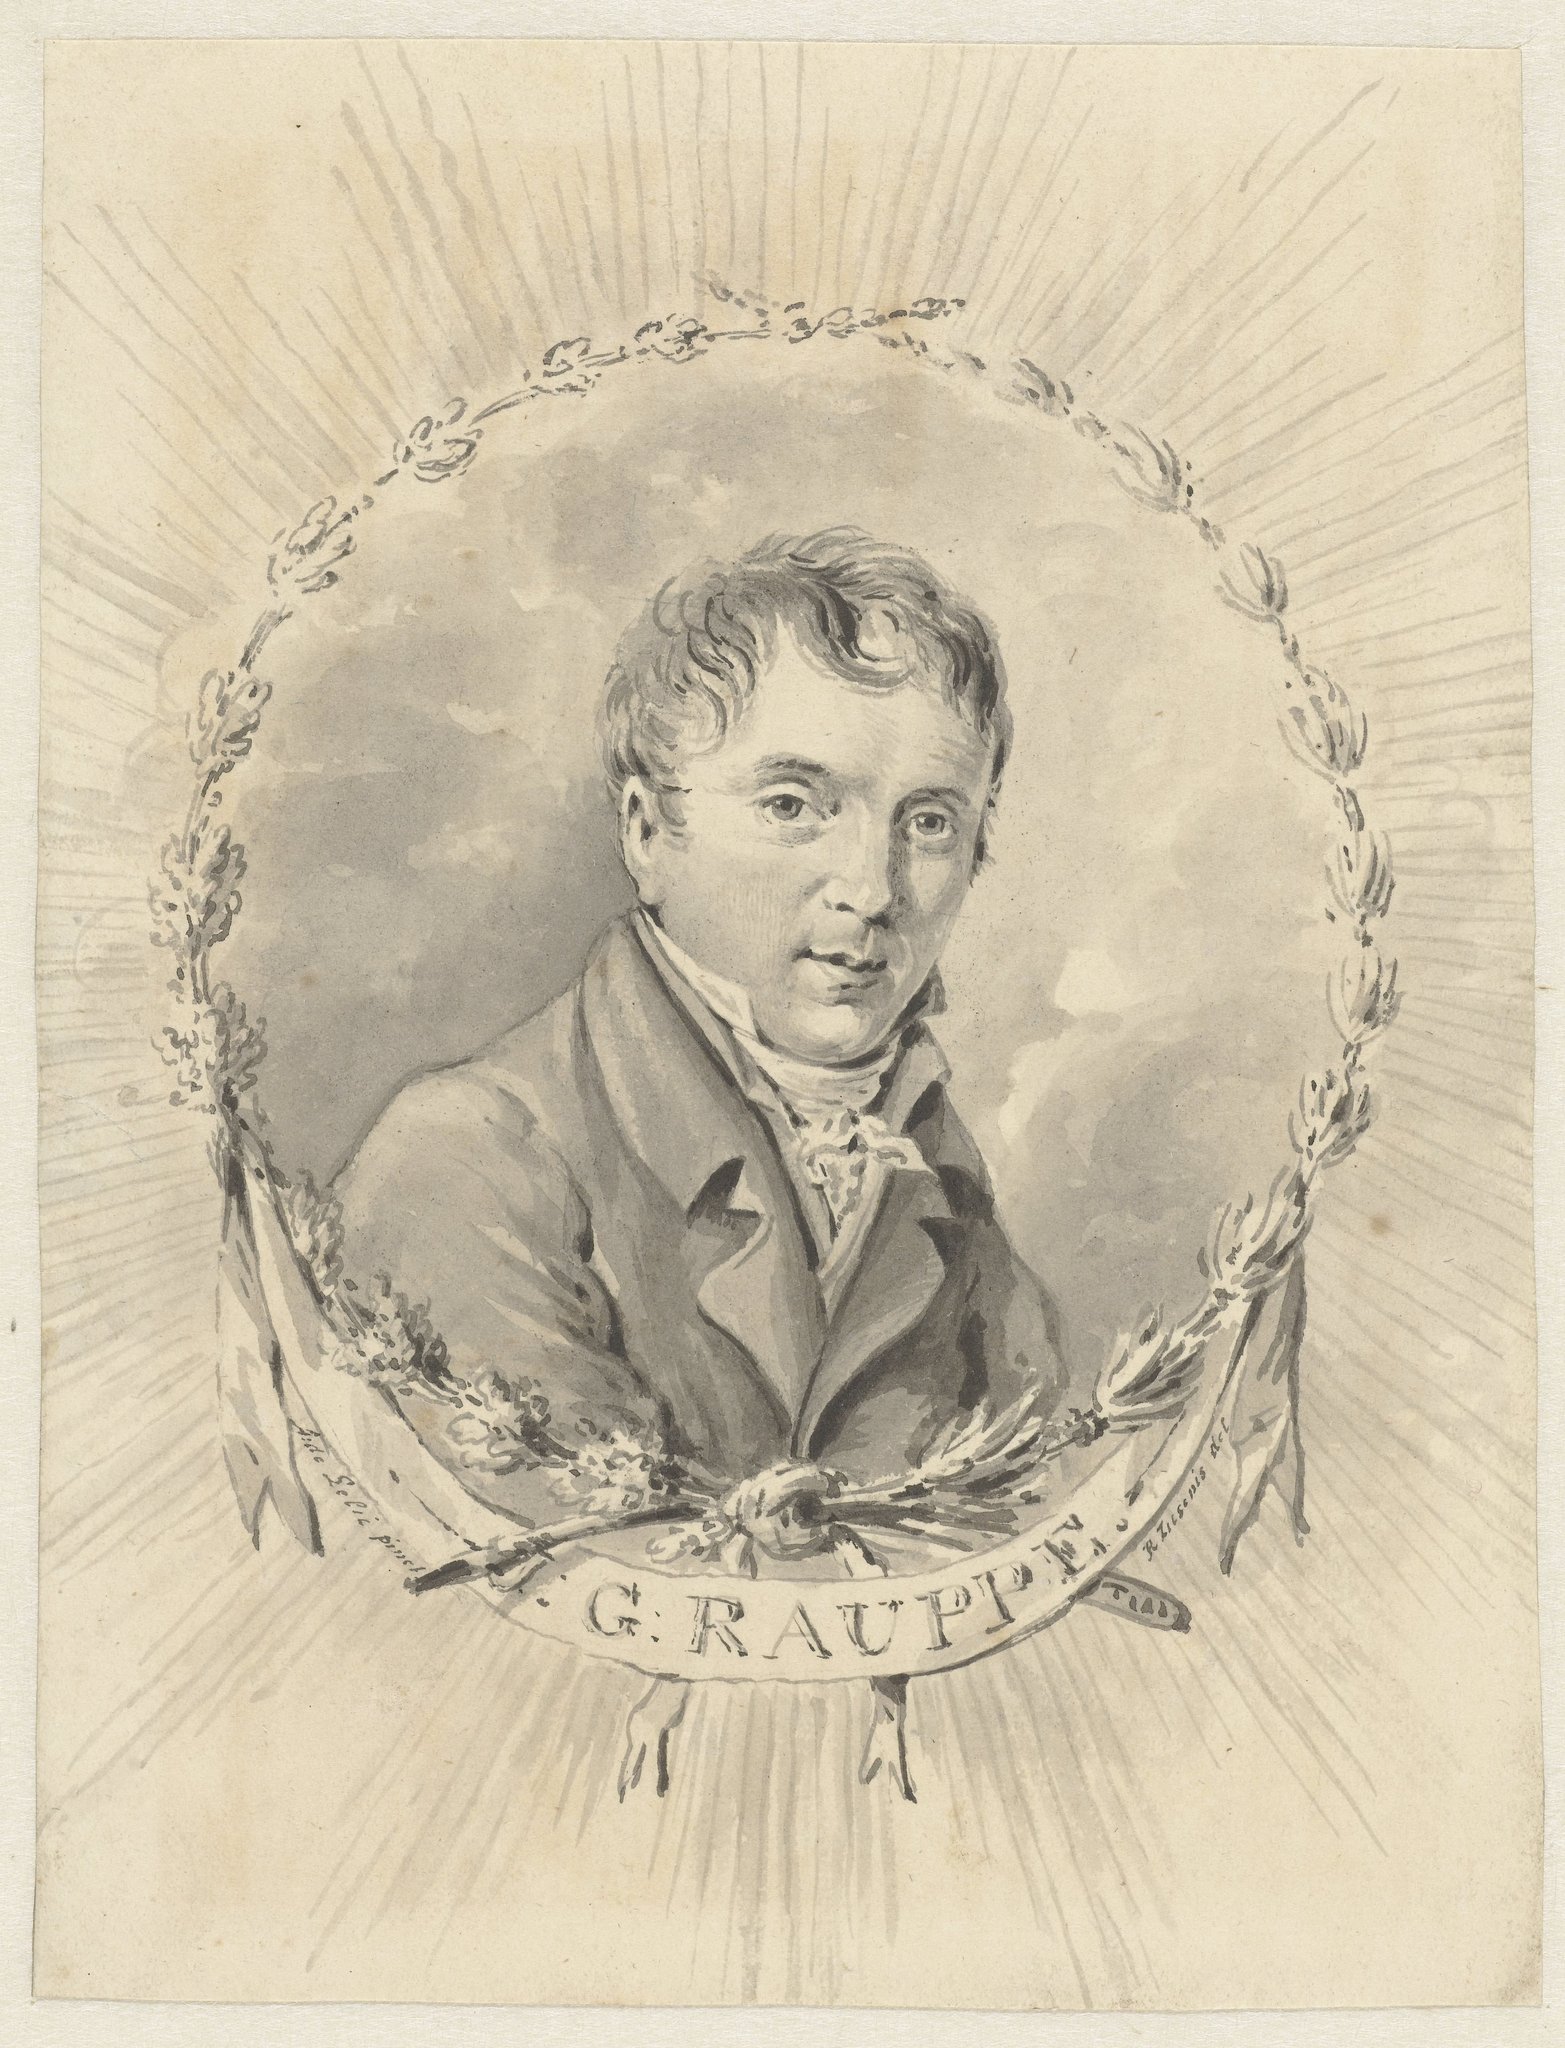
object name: drawing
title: Portret van Jan George Rauppe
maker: reinier ziesenis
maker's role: draughtsman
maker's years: 1776-1818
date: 1786-1818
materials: paper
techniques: brush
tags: historical persons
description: Portret van de violoncellist Jan George Rauppe.